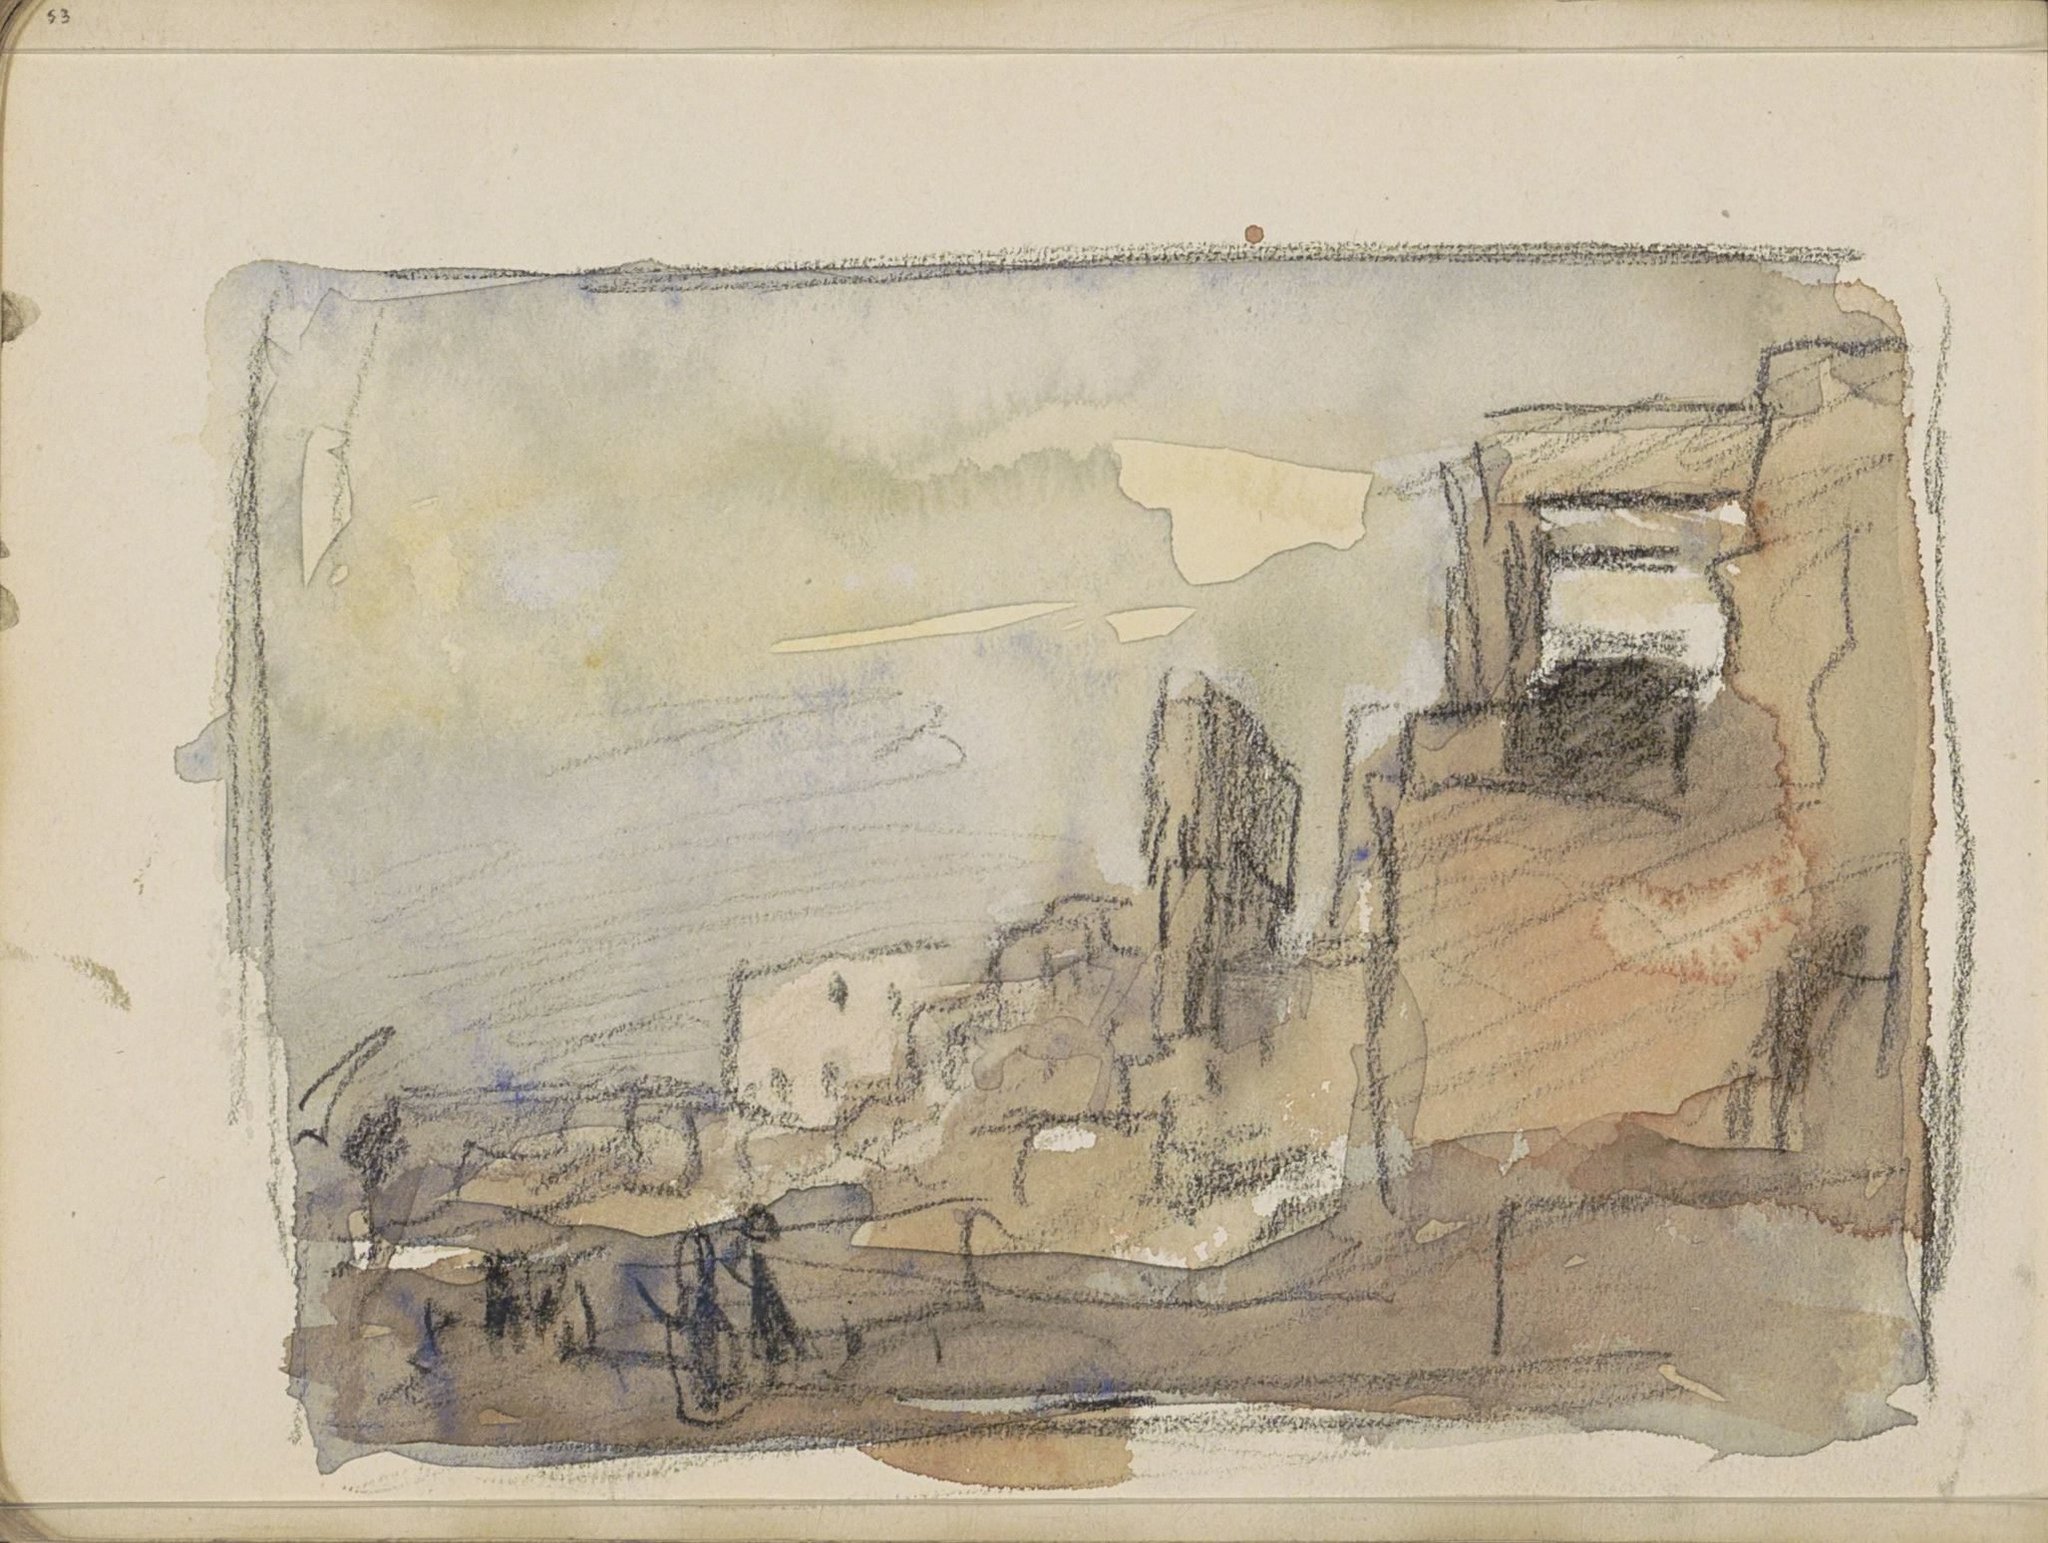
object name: sketchbook leaf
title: Gezicht op Luxor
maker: marius bauer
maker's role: draughtsman, print maker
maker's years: 1867-1932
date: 1919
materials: chalk, paper, watercolor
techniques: brush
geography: luxor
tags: city-view, and landscape with man-made constructions, landscapes (+ landscape with figures, staffage)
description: Pagina 53 uit een schetsboek met 28 bladen.